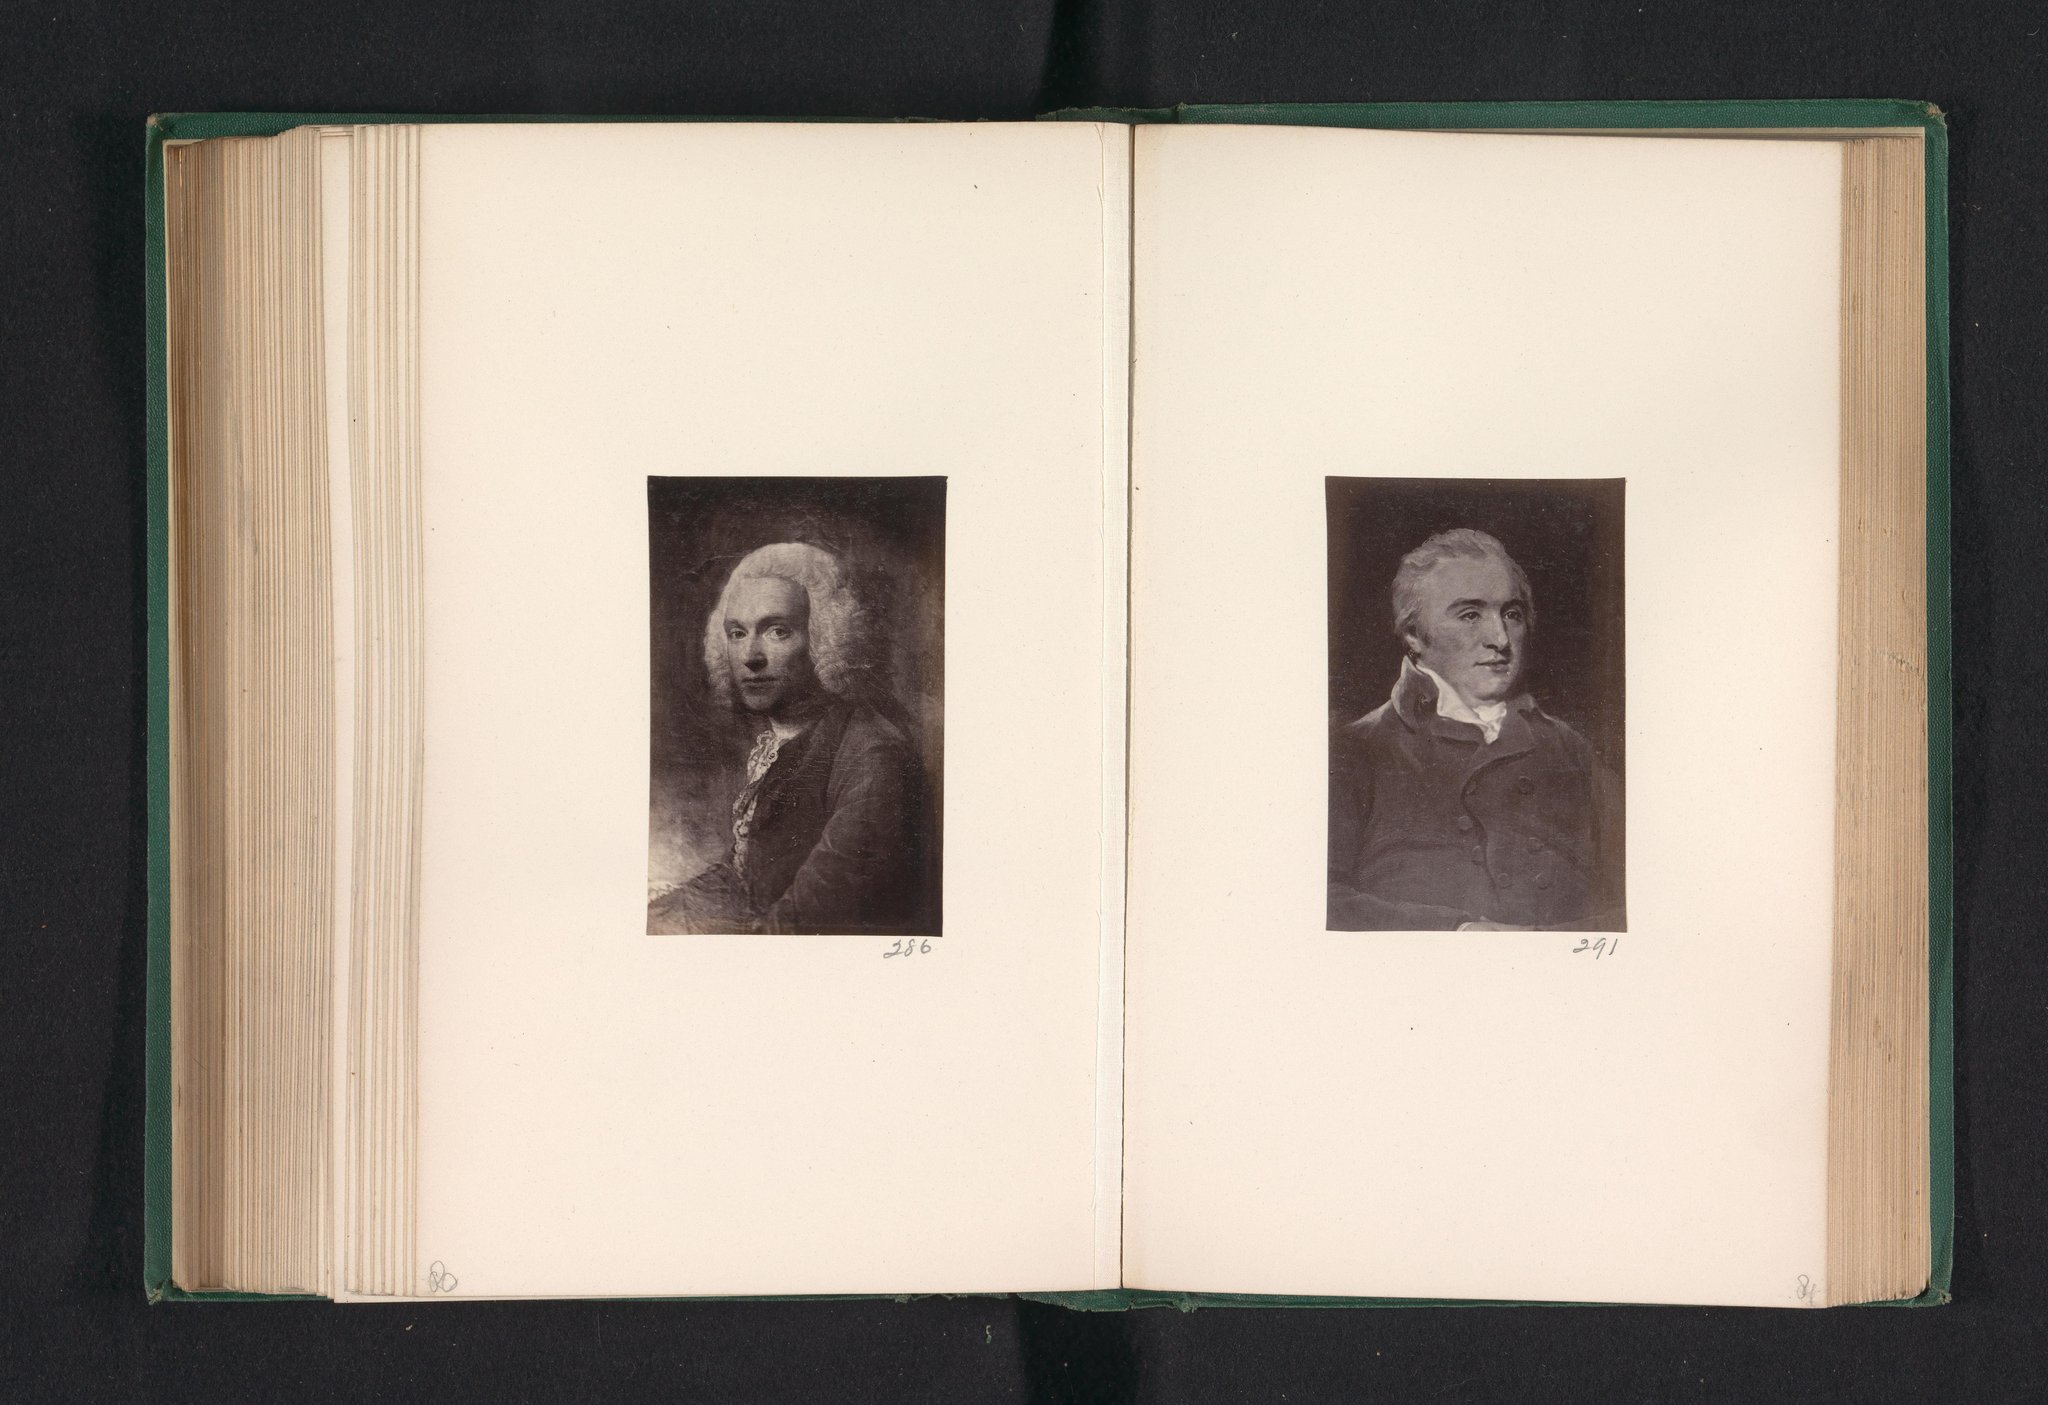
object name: page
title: Fotoreproductie van een schilderij, voorstellende een portret van Matthew Baillie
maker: thomas annan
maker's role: fotograaf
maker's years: 1829-1887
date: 1863-1868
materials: photographic support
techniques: albumen print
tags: physicist, historical persons (portraits and scenes from the life) (+ (full) bust portrait)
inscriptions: number: ‘291’